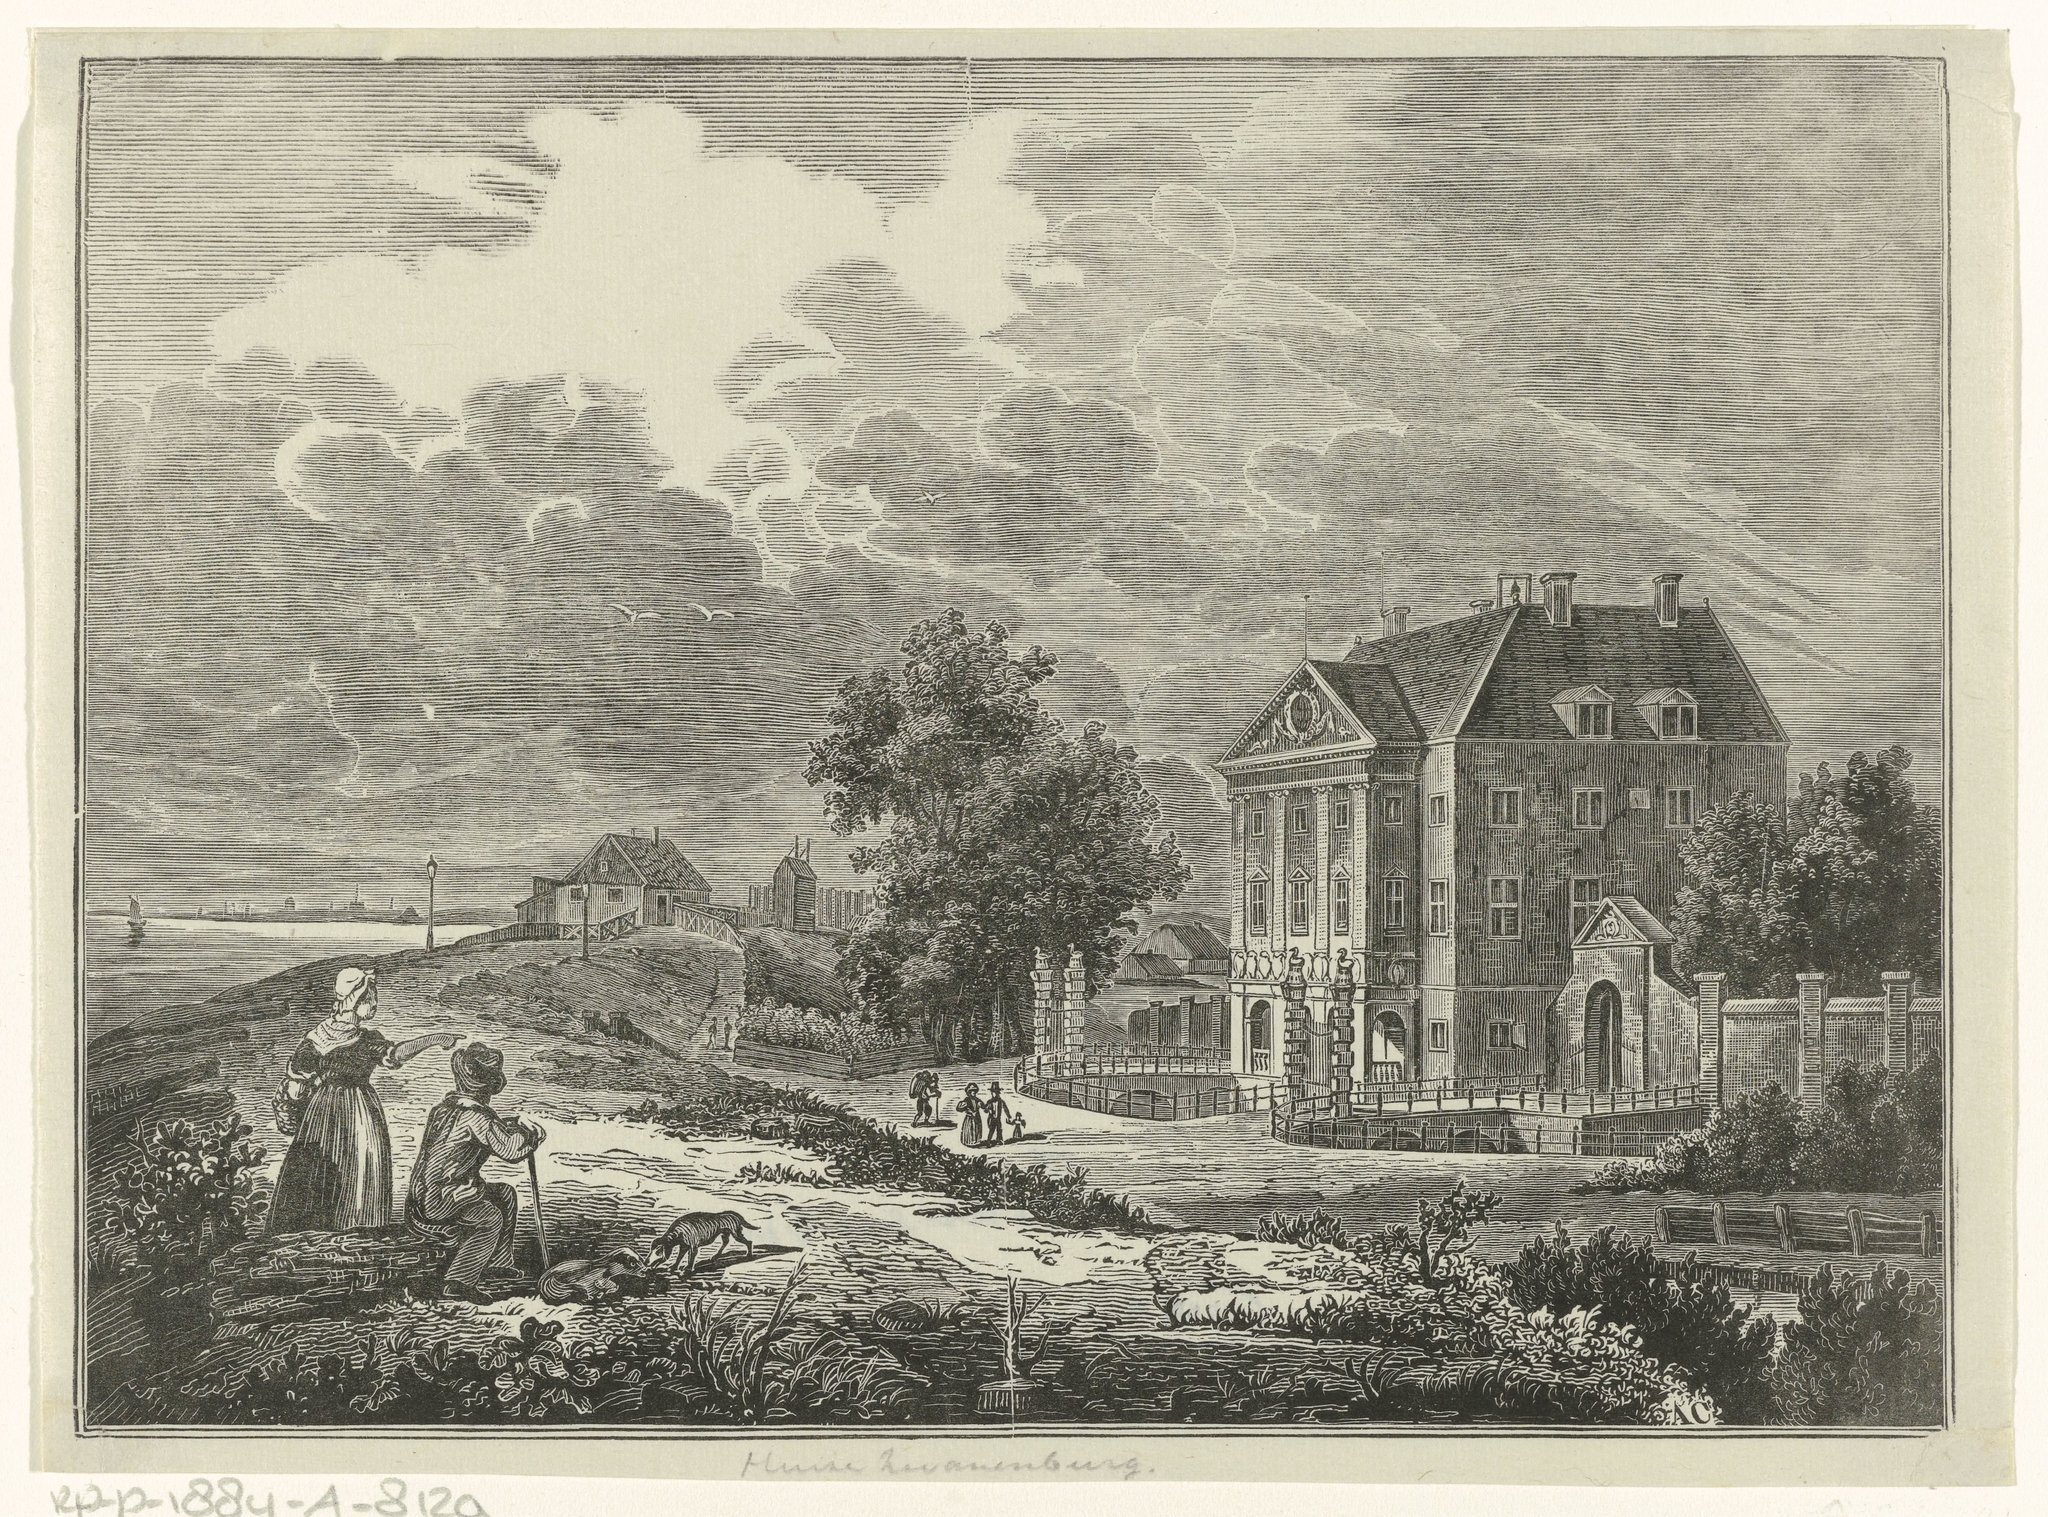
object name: print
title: Gezicht op Huis Zwanenburg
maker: alexander cranendoncq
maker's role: draughtsman, print maker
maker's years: 1799-1869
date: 1809-1869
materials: paper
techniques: engraving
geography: netherlands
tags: dog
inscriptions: collector's mark: Lugt 2228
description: Op de voorgrond zit een man met een stok en twee honden. Naast hem staat een vrouw met een mand die naar het huis wijst.